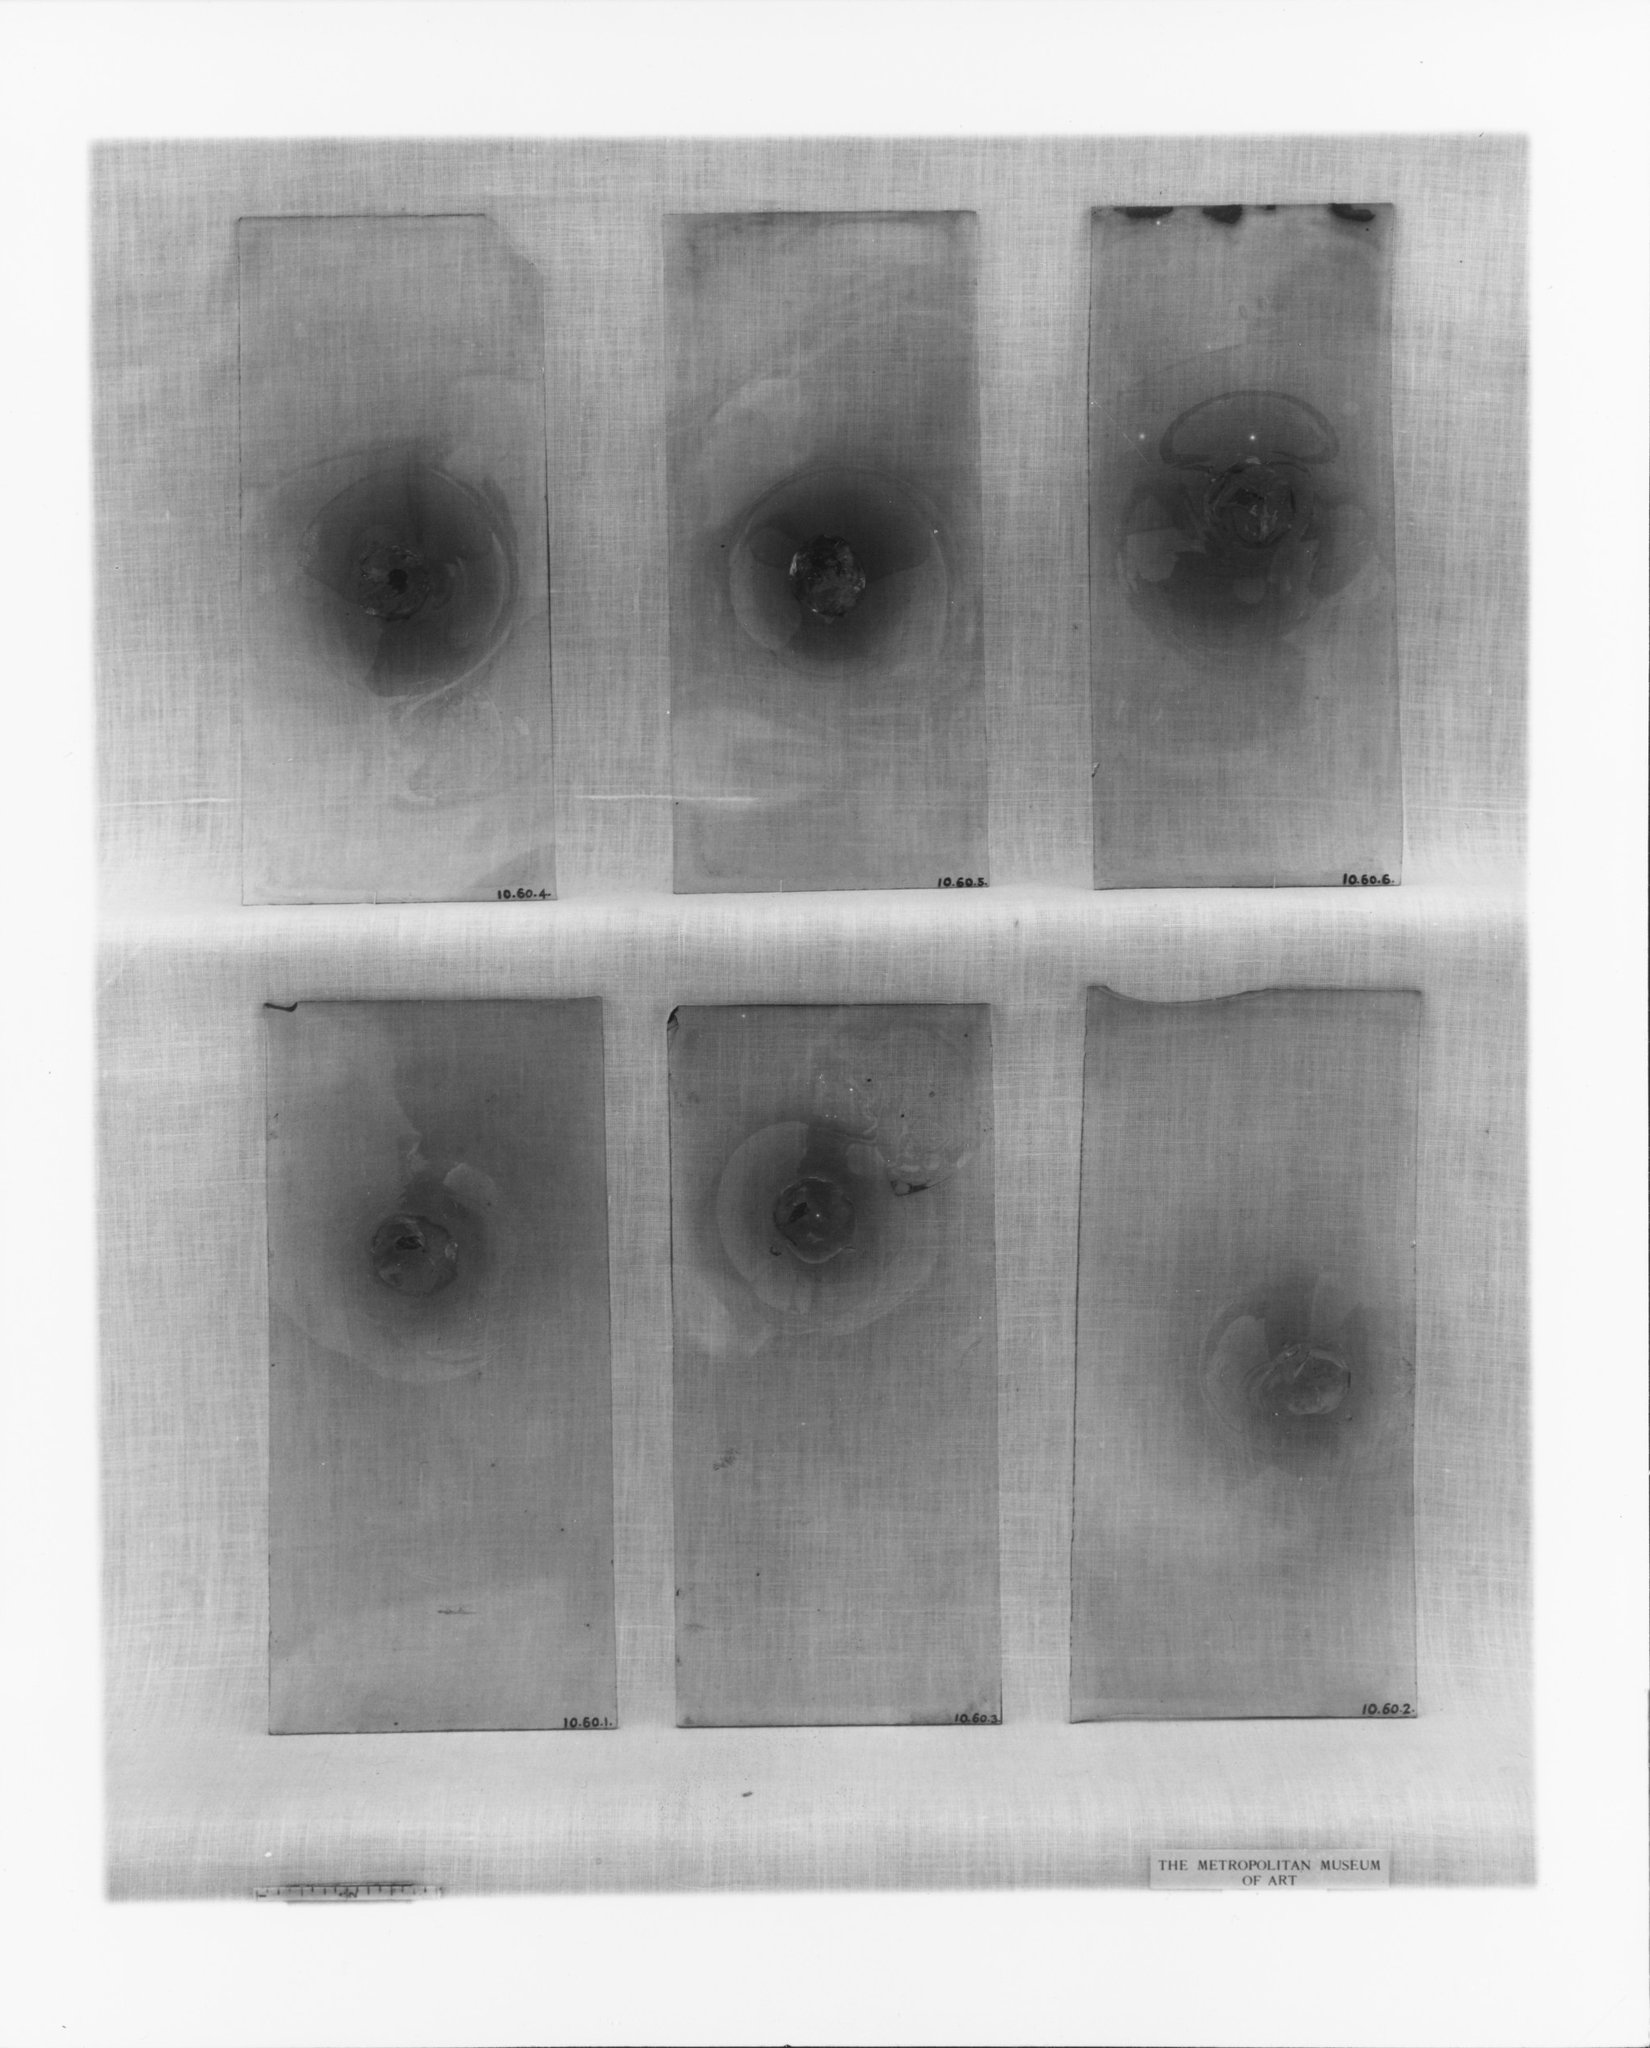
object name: windowpane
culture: american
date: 1701-1800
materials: glass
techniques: glassblowing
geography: united states